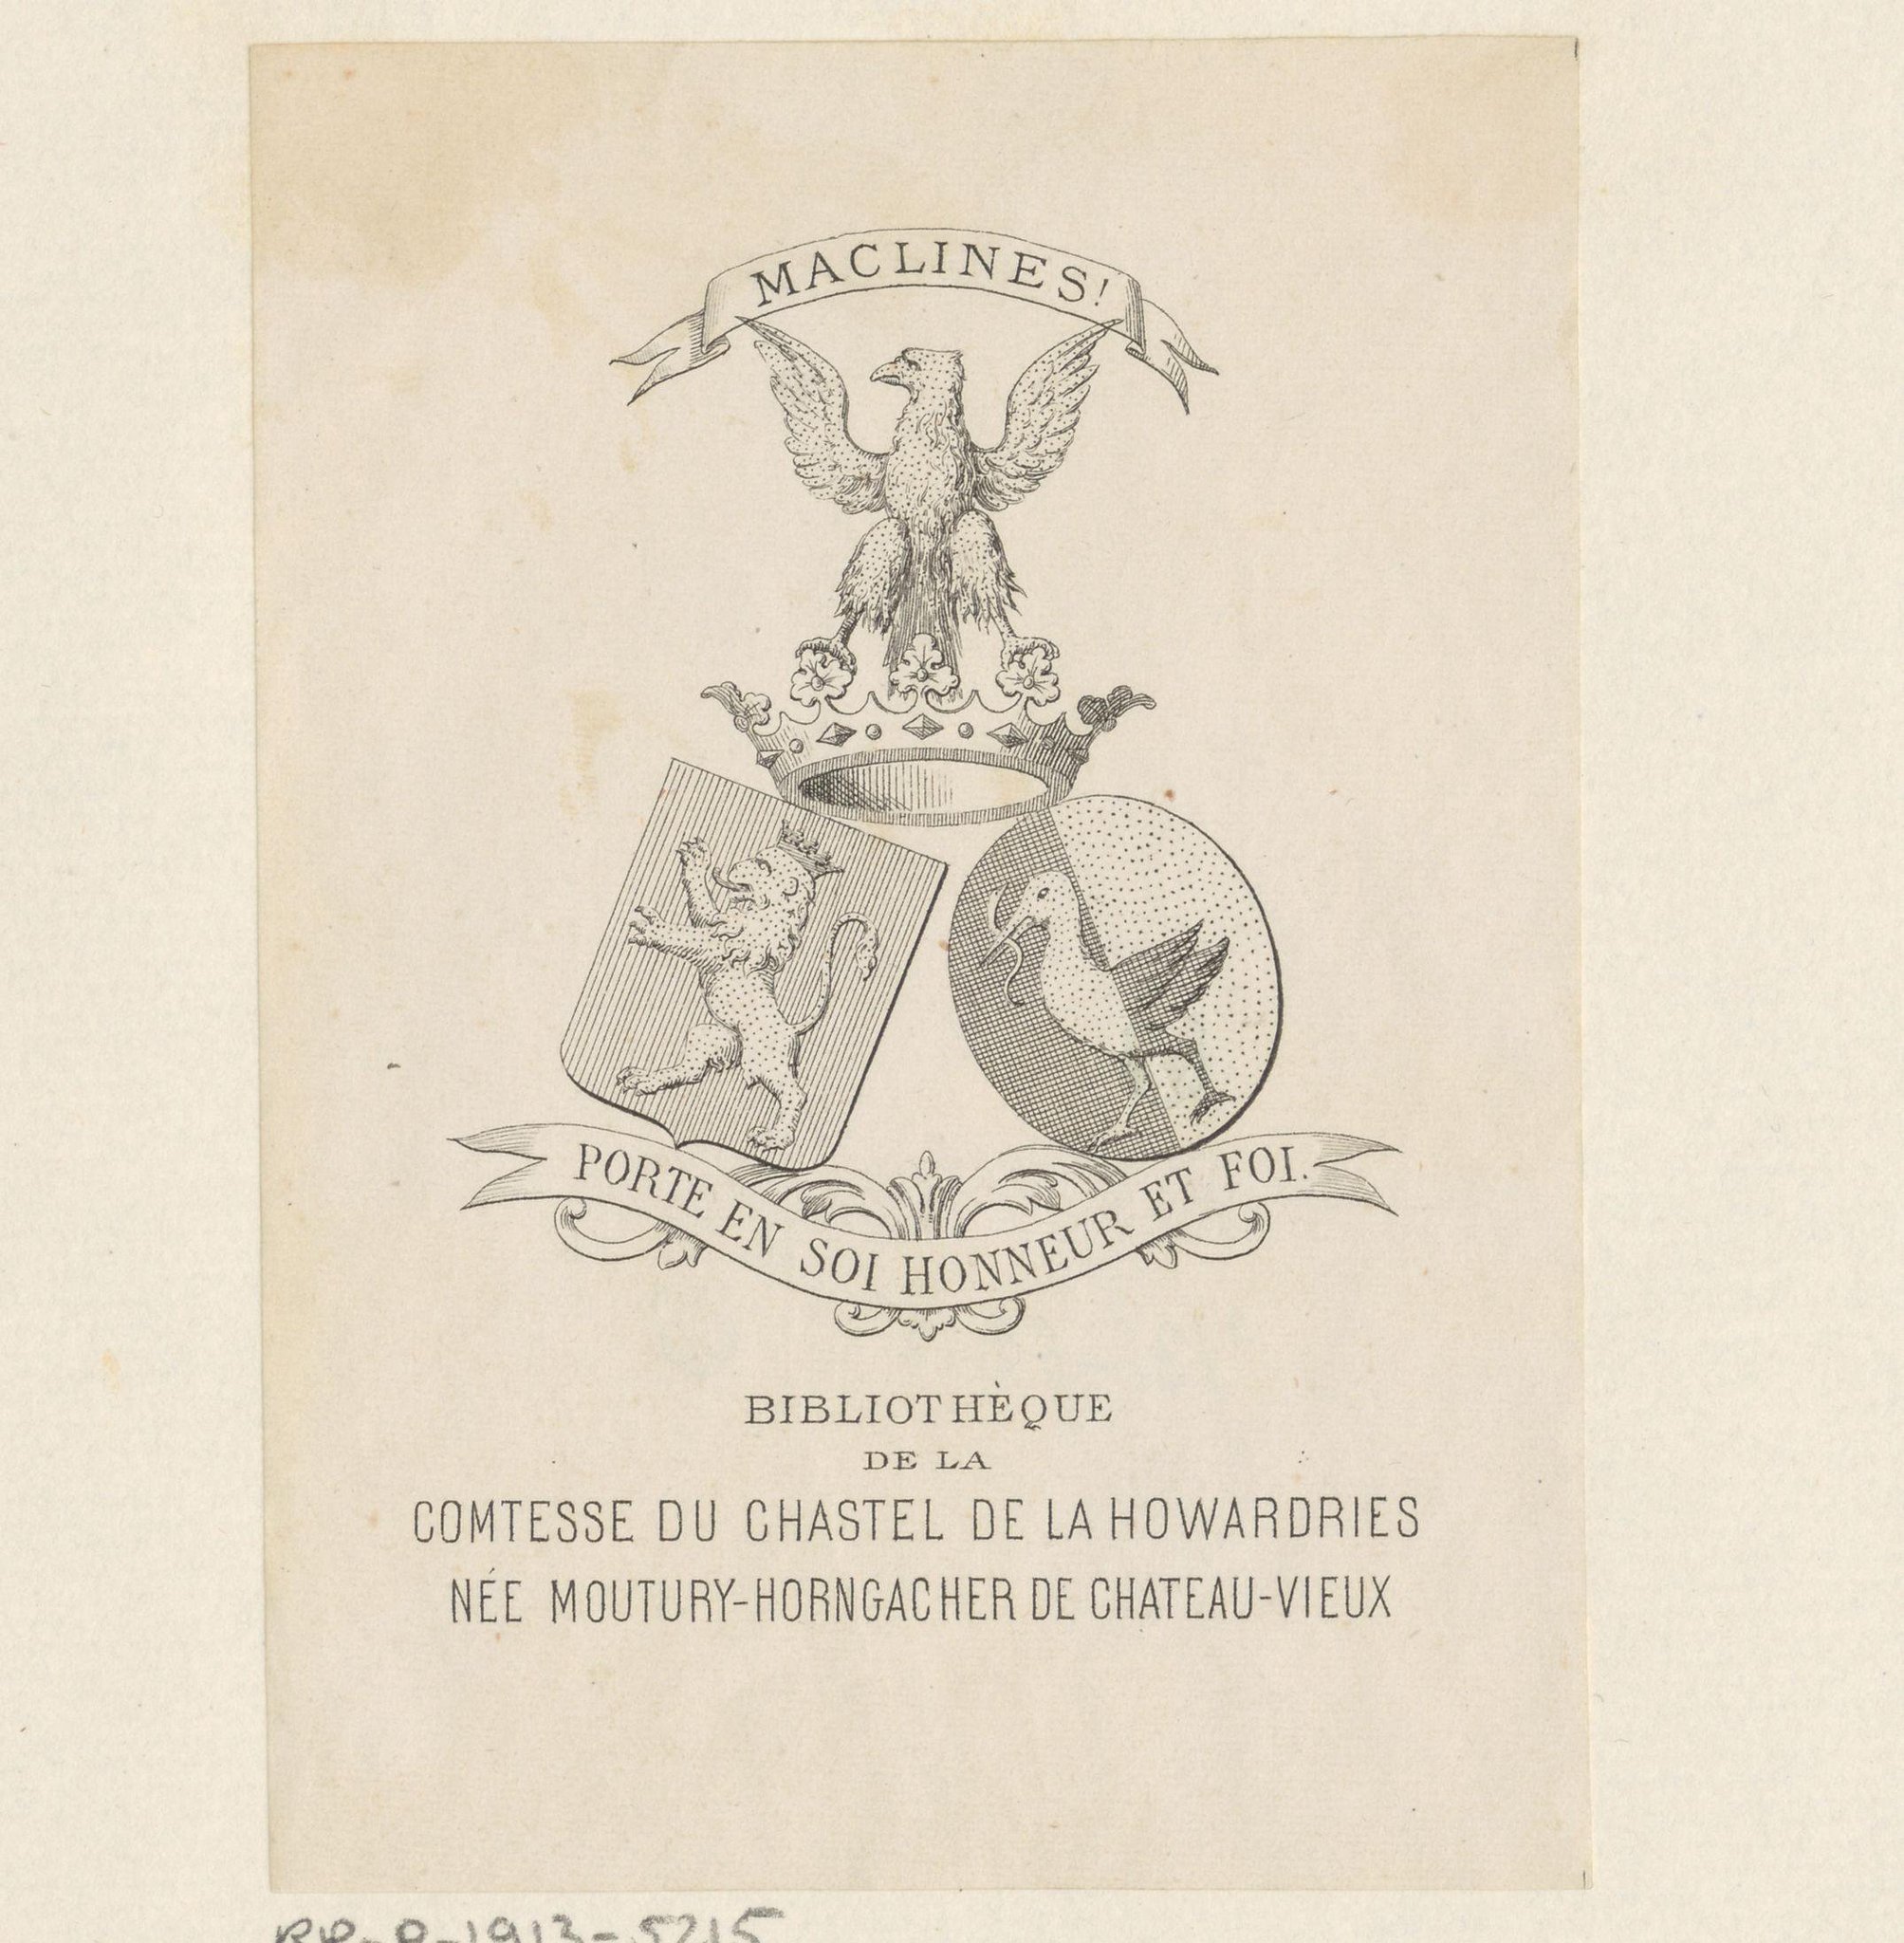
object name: bookplate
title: Ex libris van Catherine gravin du Chastel de la Howarderie-Moutury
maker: Anonymous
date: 1858-1901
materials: paper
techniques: etching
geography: belgium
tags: predatory birds: eagle, birds, beasts of prey, predatory animals: lion, armorial bearing, heraldry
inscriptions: collector's mark: Lugt 2760, collector's mark: Lugt 2233